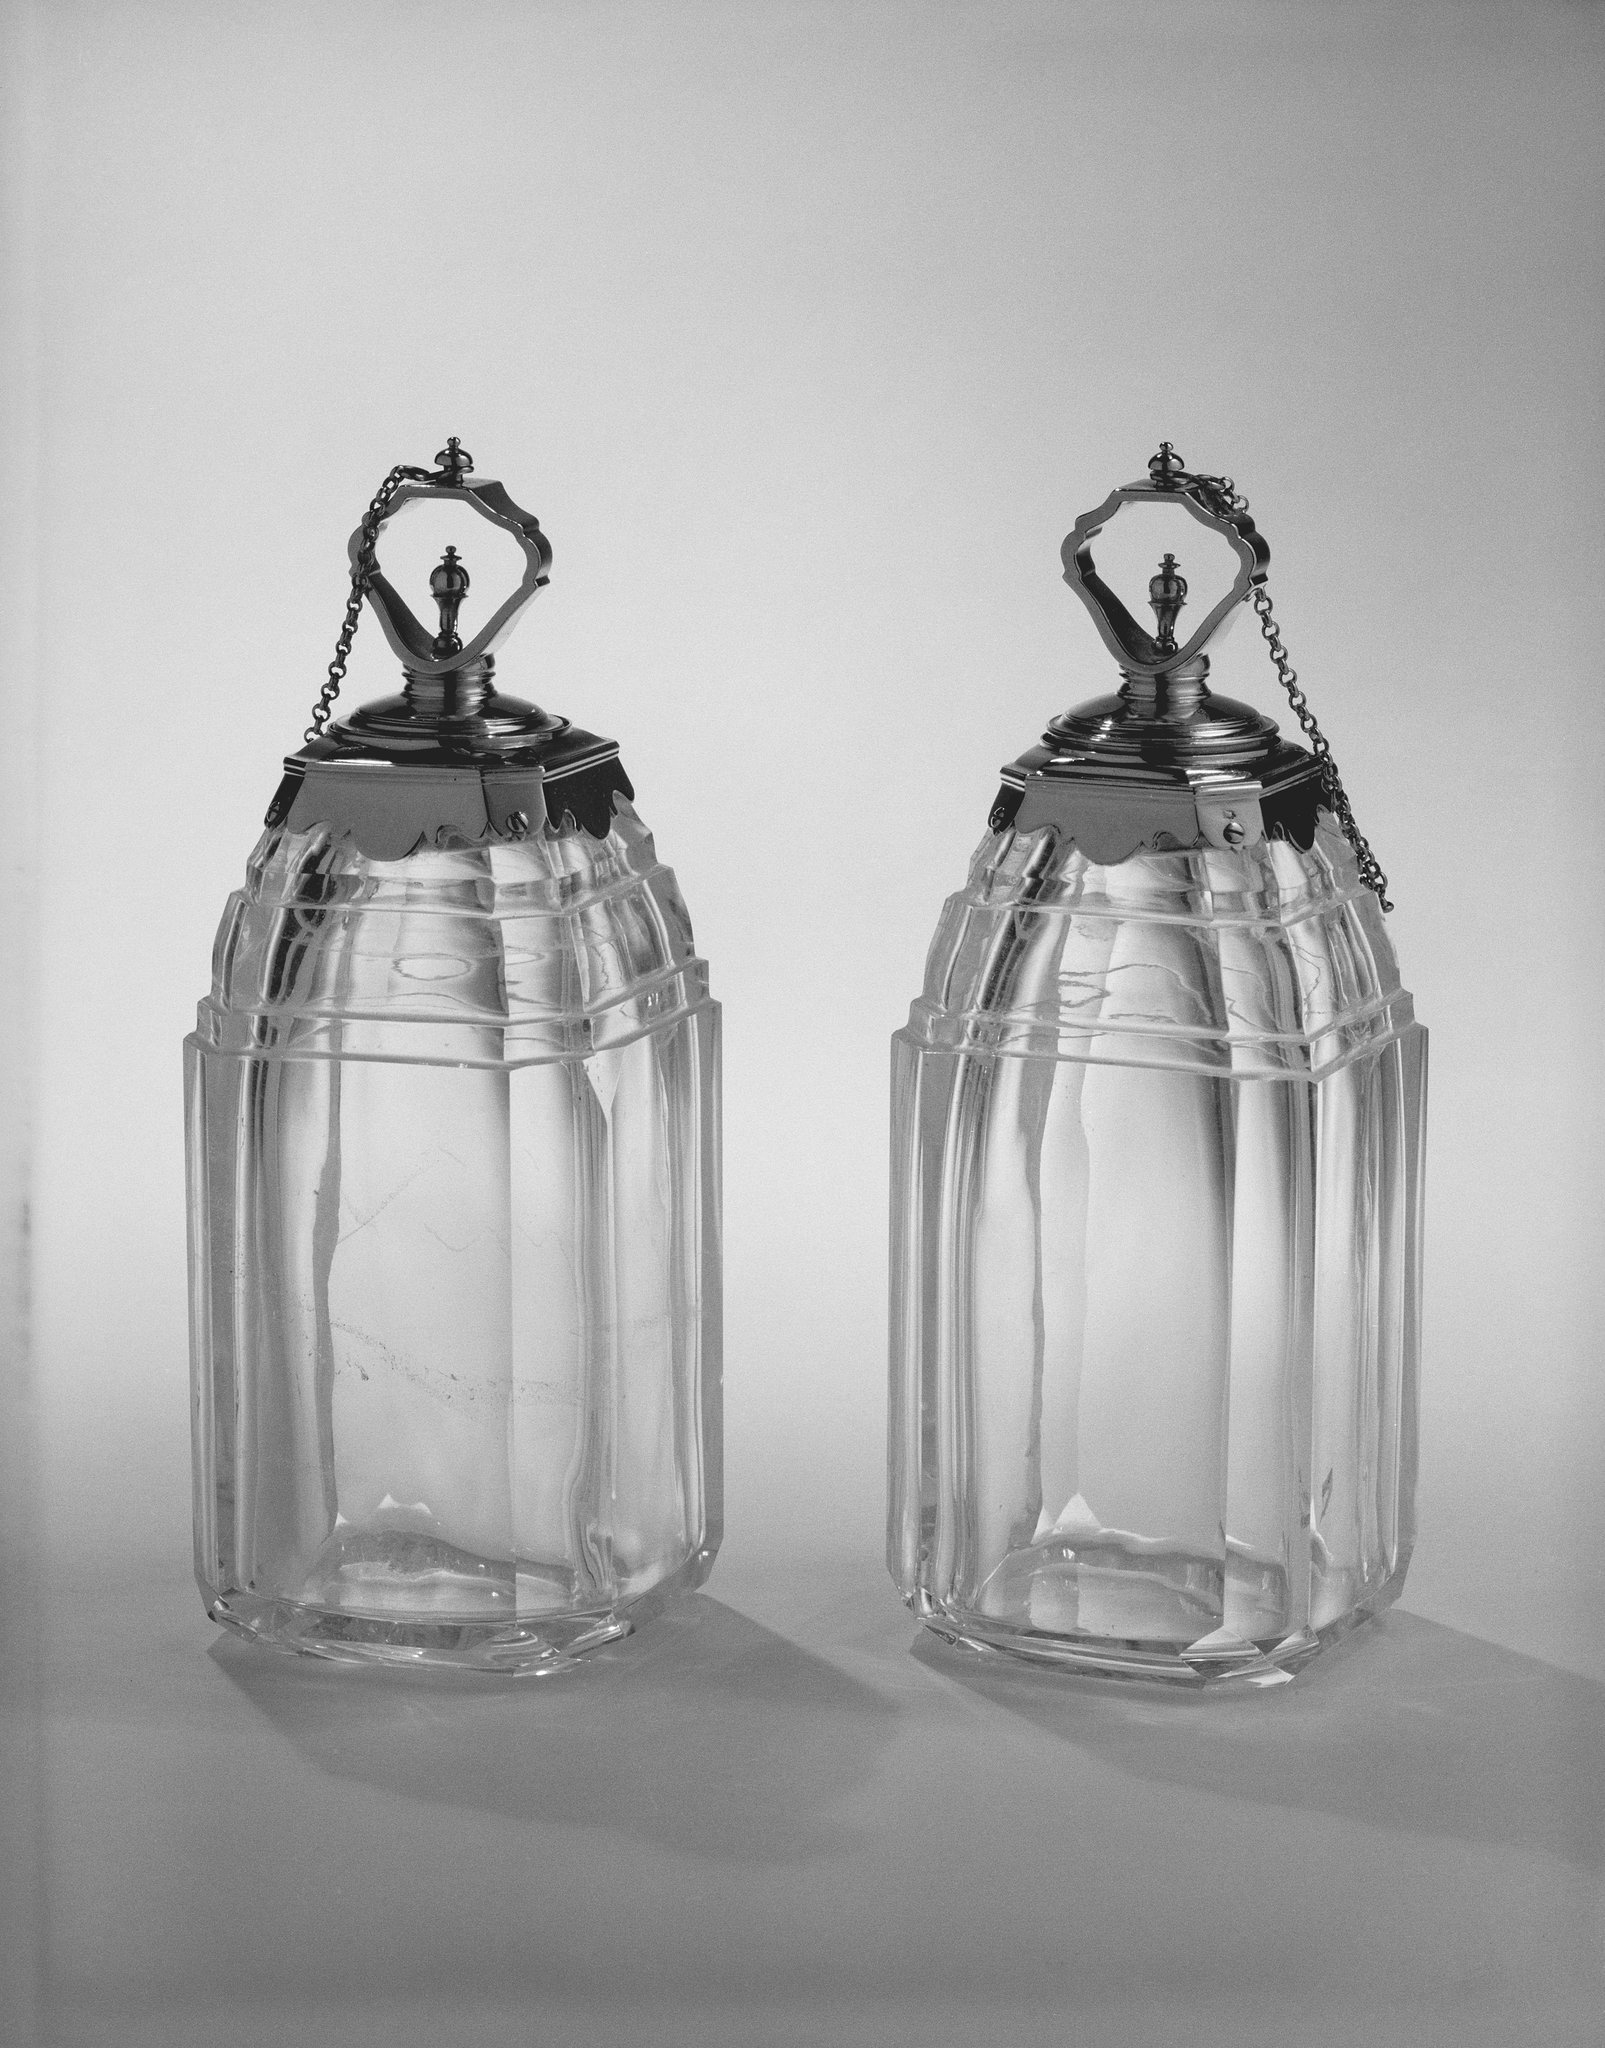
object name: perfume bottle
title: Perfume bottle (one of six) (part of a set)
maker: louis mailly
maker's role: maker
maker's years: 1639-1739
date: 1728-1730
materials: gold, quartz